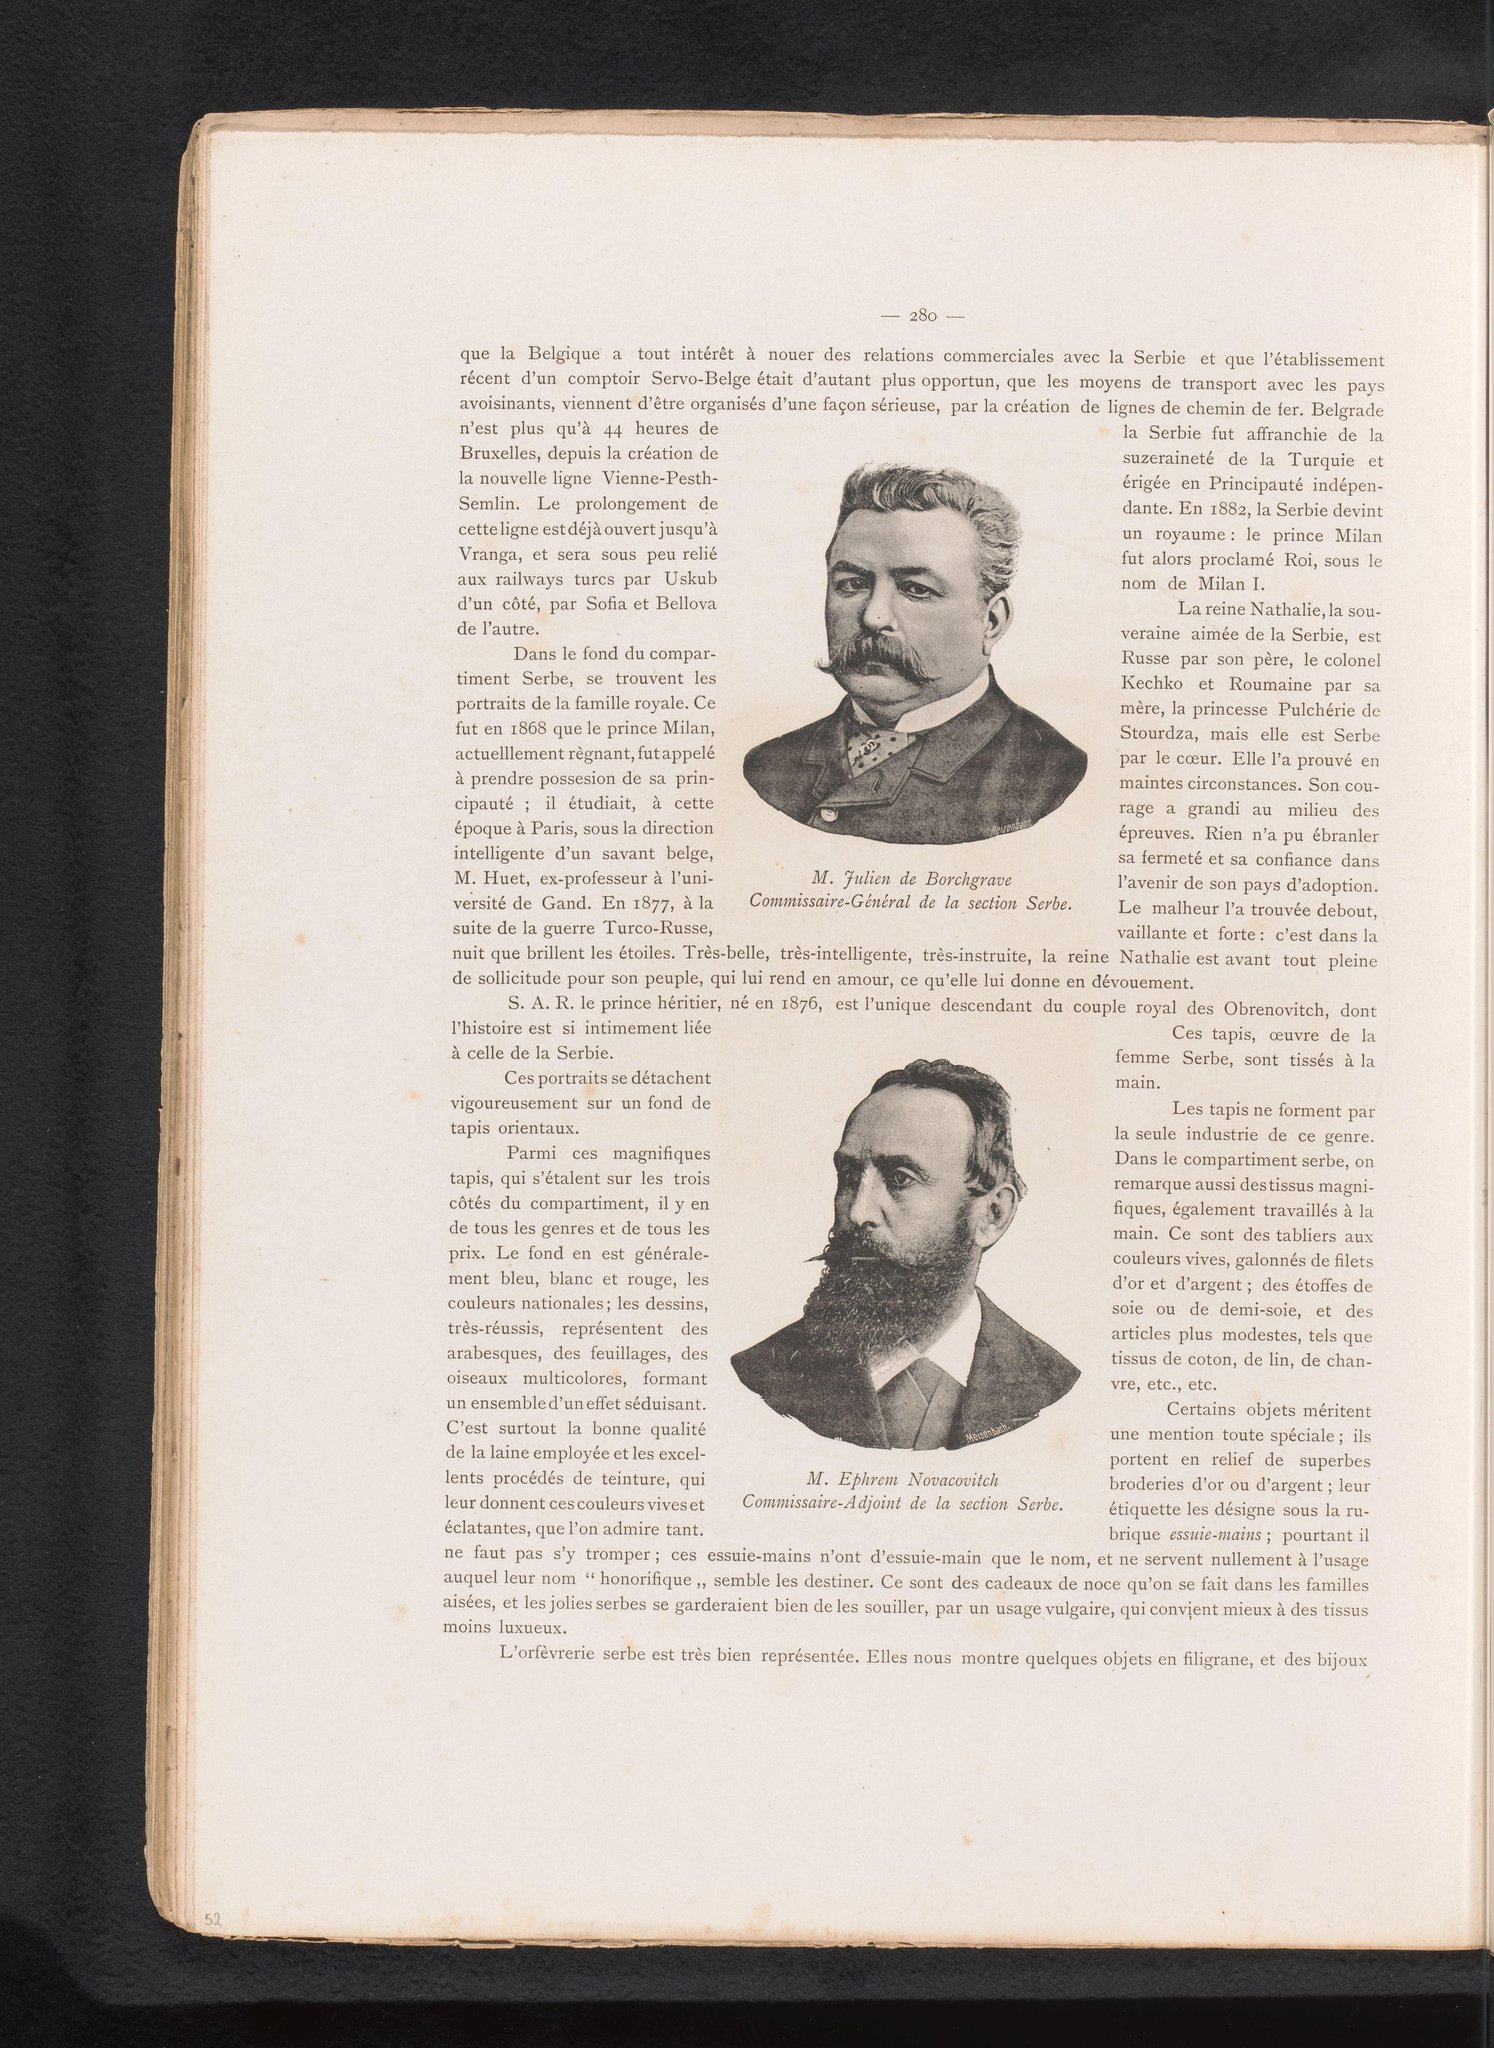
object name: page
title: M. Ephrem Novacovitch, Commissaire-Adjoint de la section Serbe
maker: Anonymous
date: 1880-1885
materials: paper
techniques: autotype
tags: historical persons